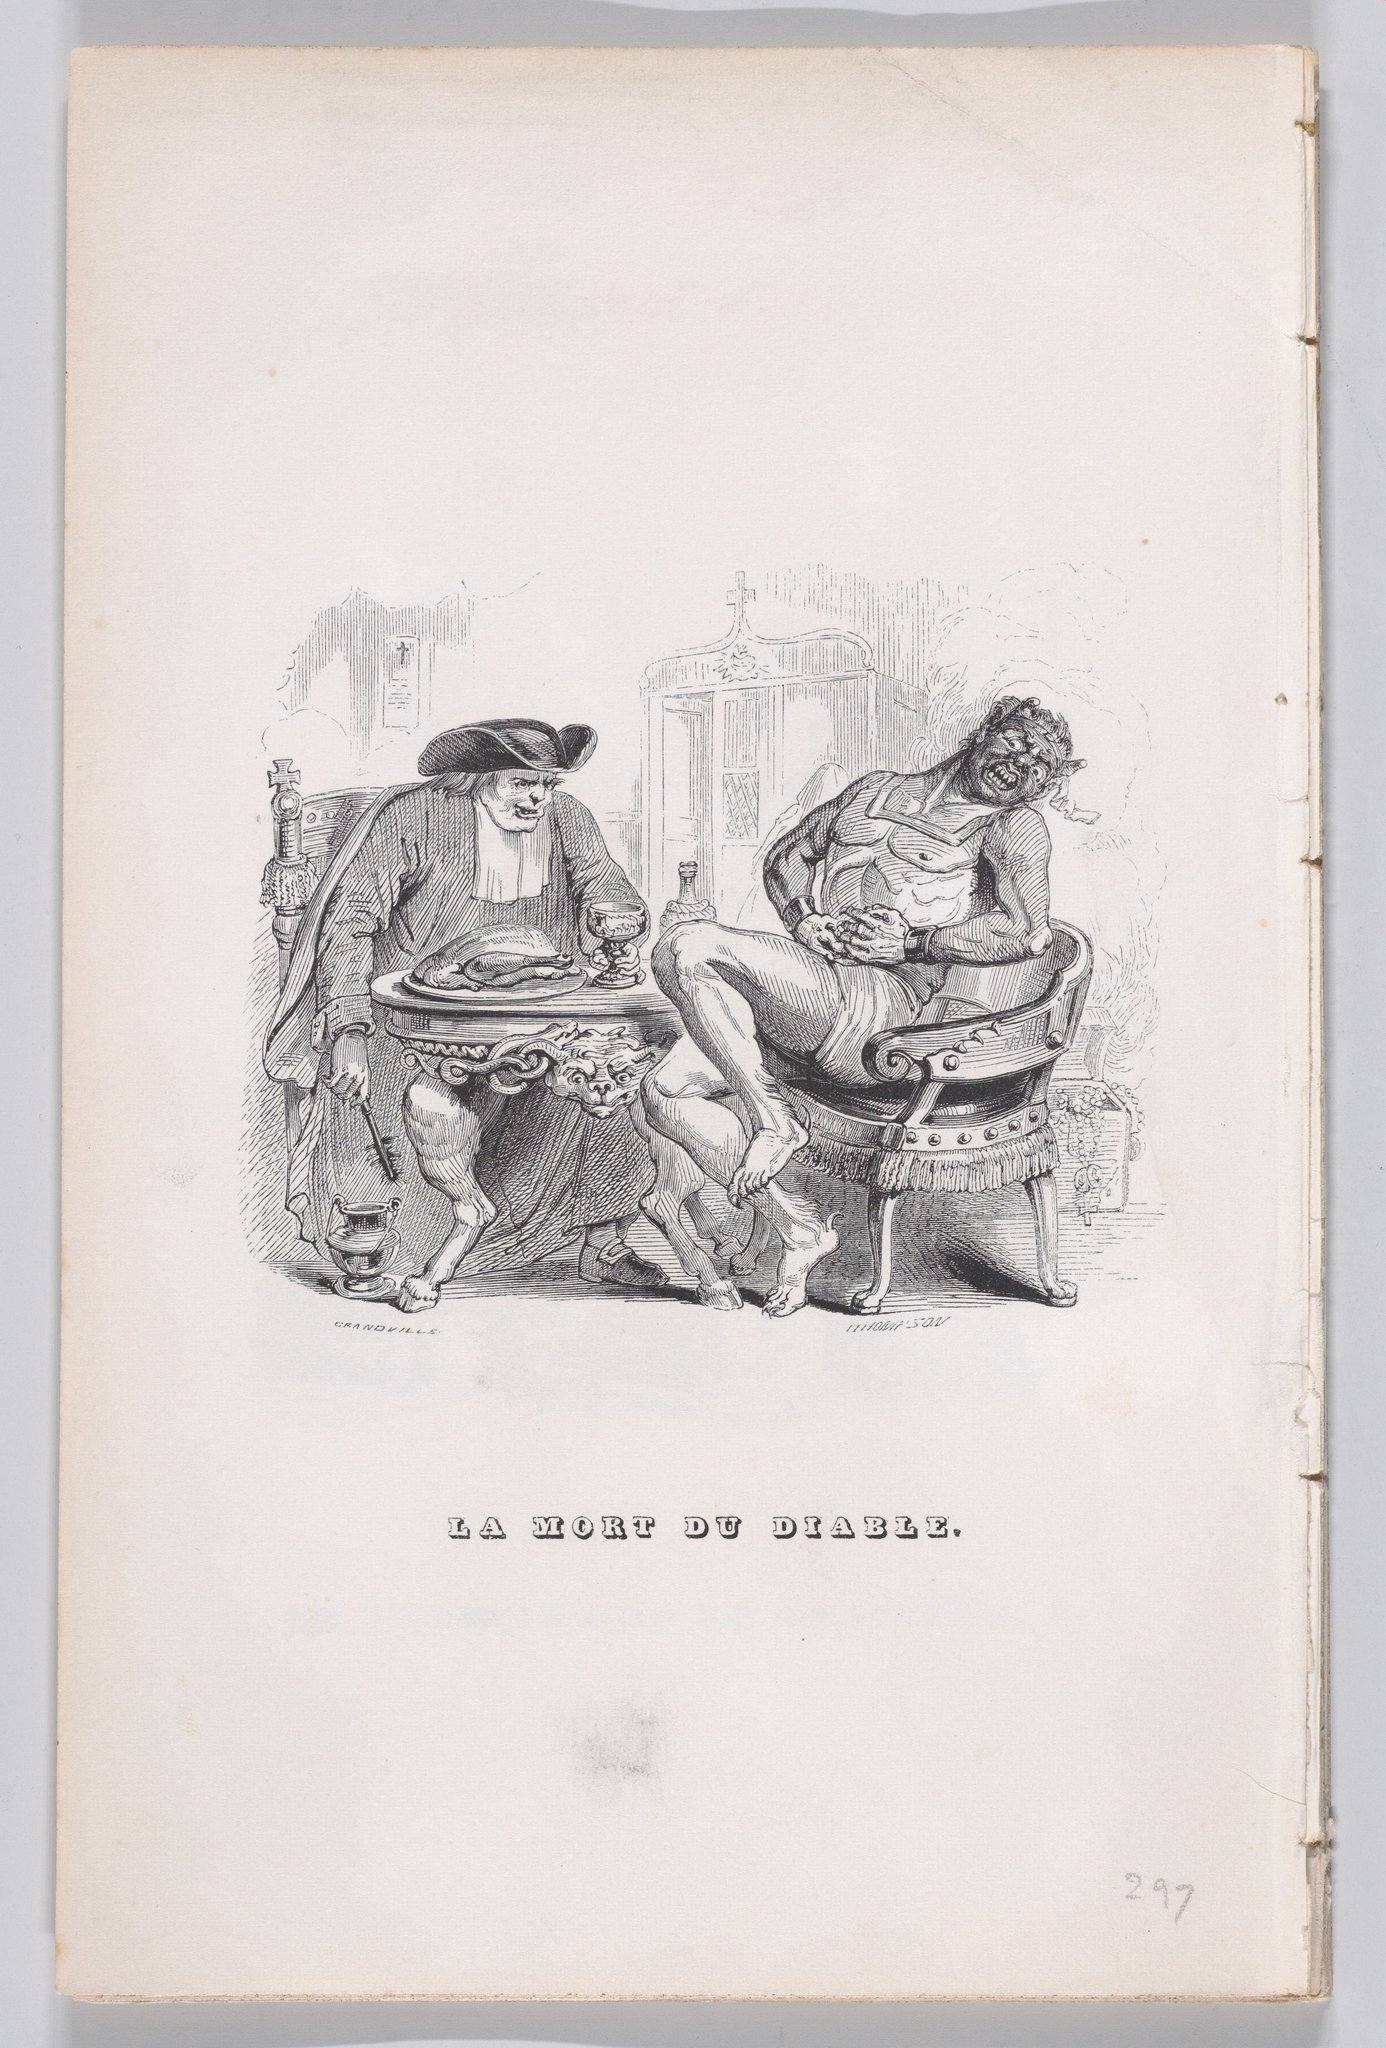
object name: print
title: The Death of the Devil, from "The Complete Works of Béranger"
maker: j. j. grandville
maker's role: illustrator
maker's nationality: french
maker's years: 1803-1847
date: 1836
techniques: engraving